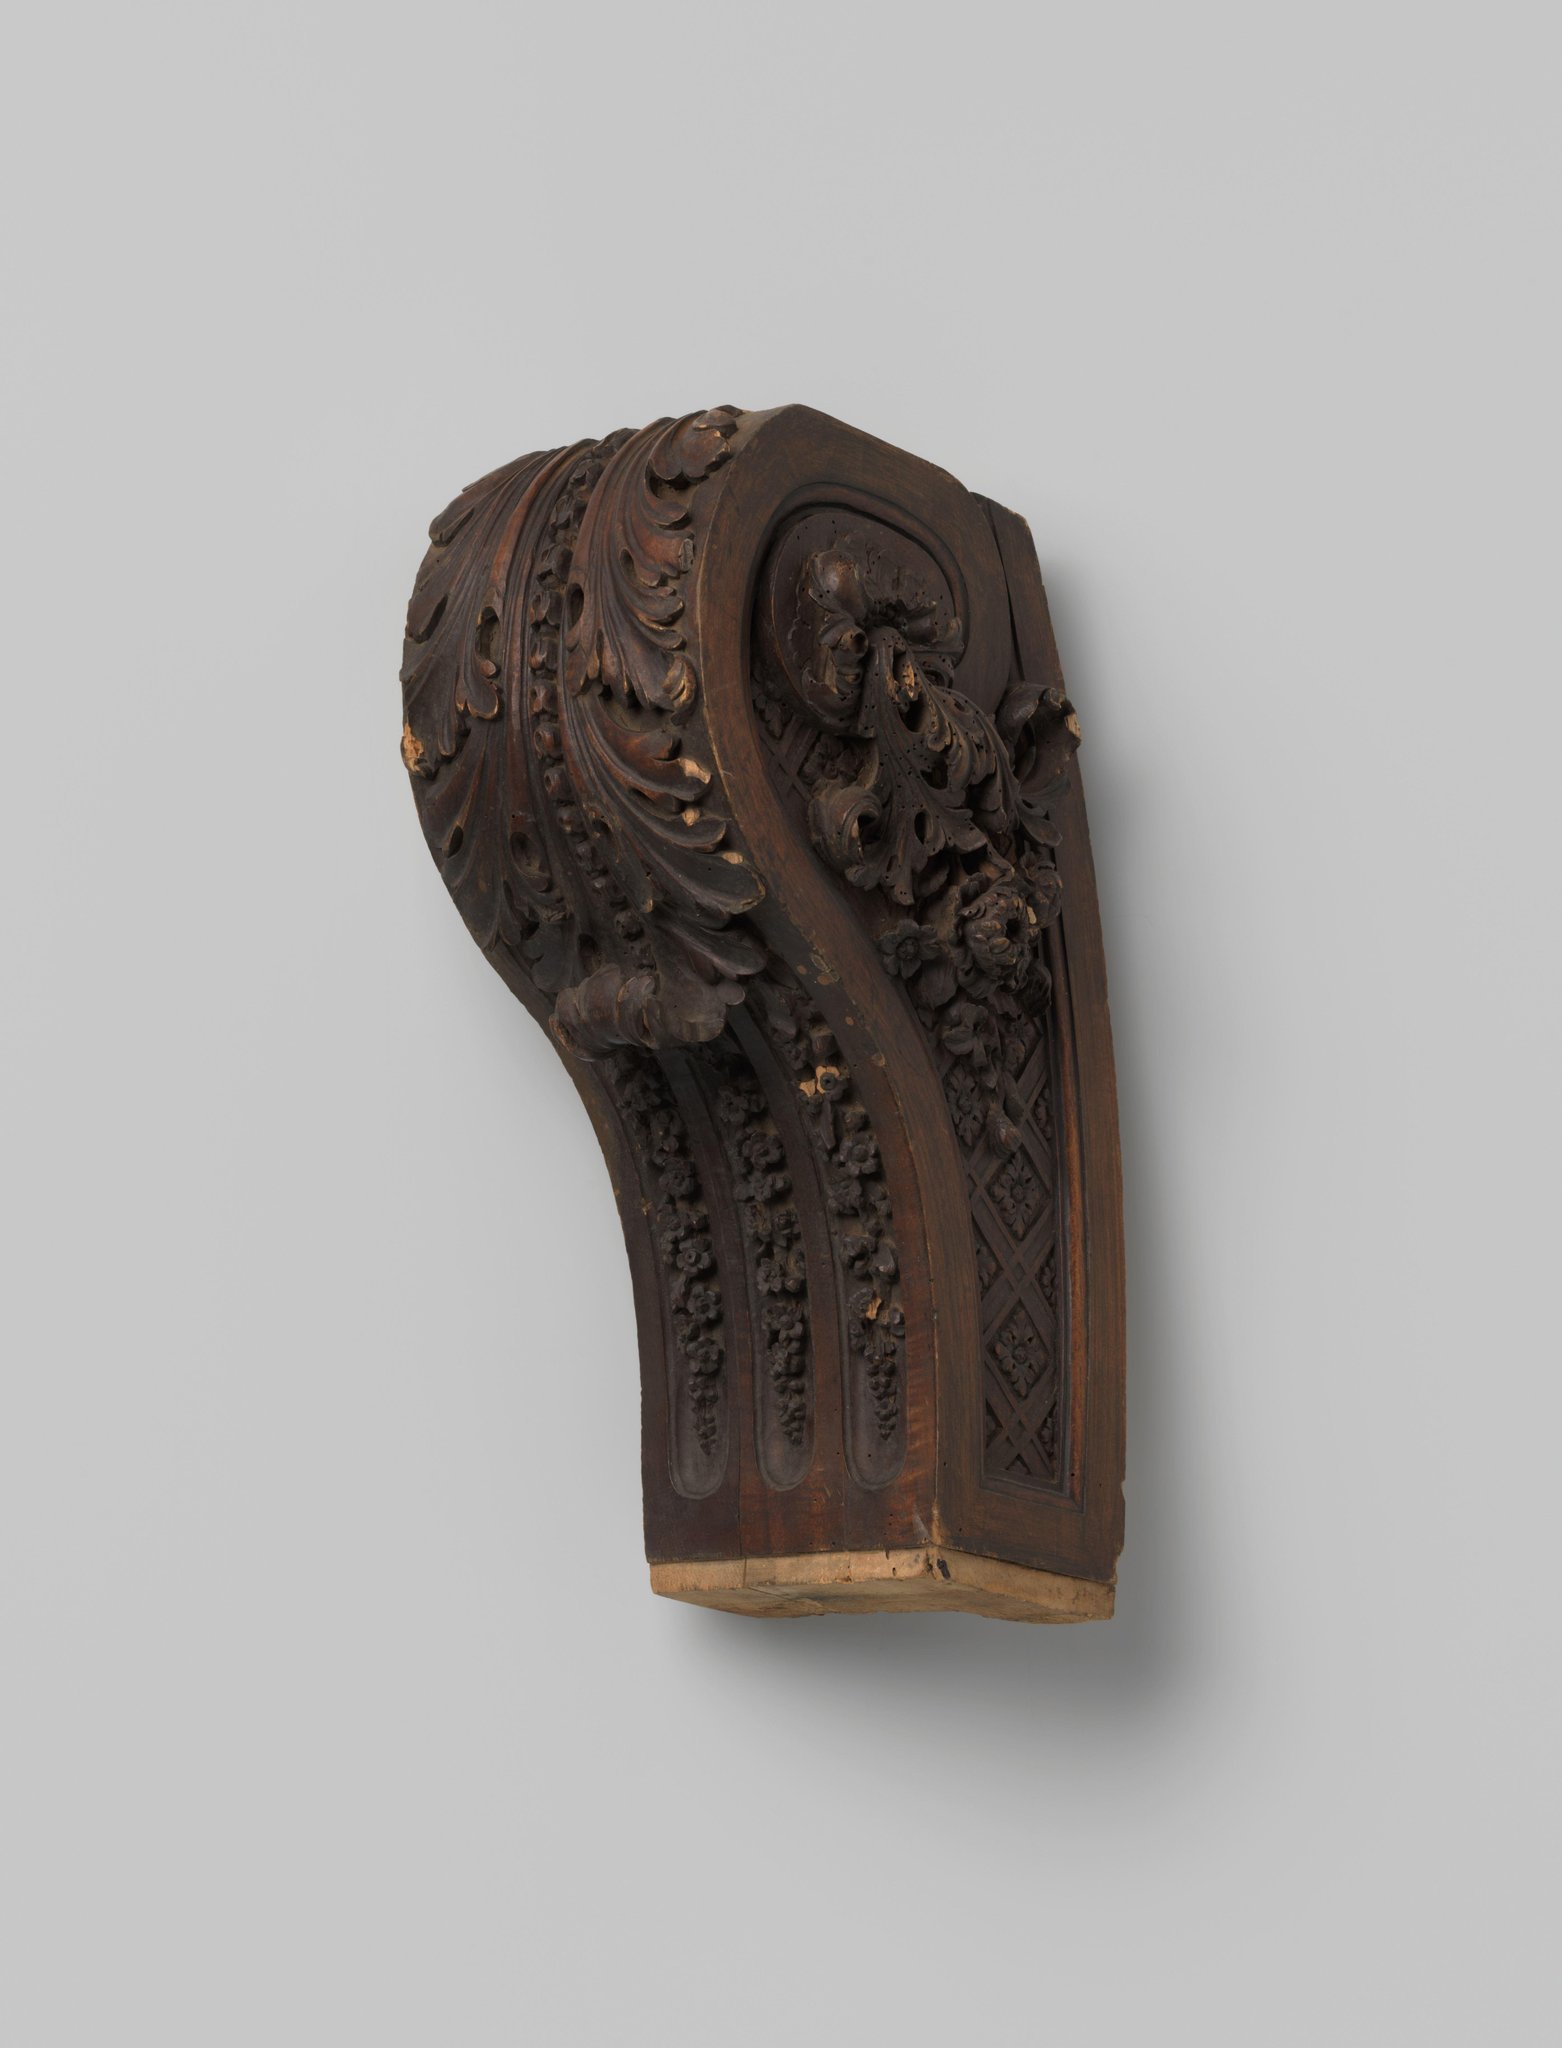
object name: architectural element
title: Console, afkomstig uit Huis de Voorst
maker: Anonymous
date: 1700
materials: wood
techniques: stain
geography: northern netherlands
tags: huis de voorst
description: Houten console, versierd met snijwerk in de vorm van een staand acanthusblad en ranken.